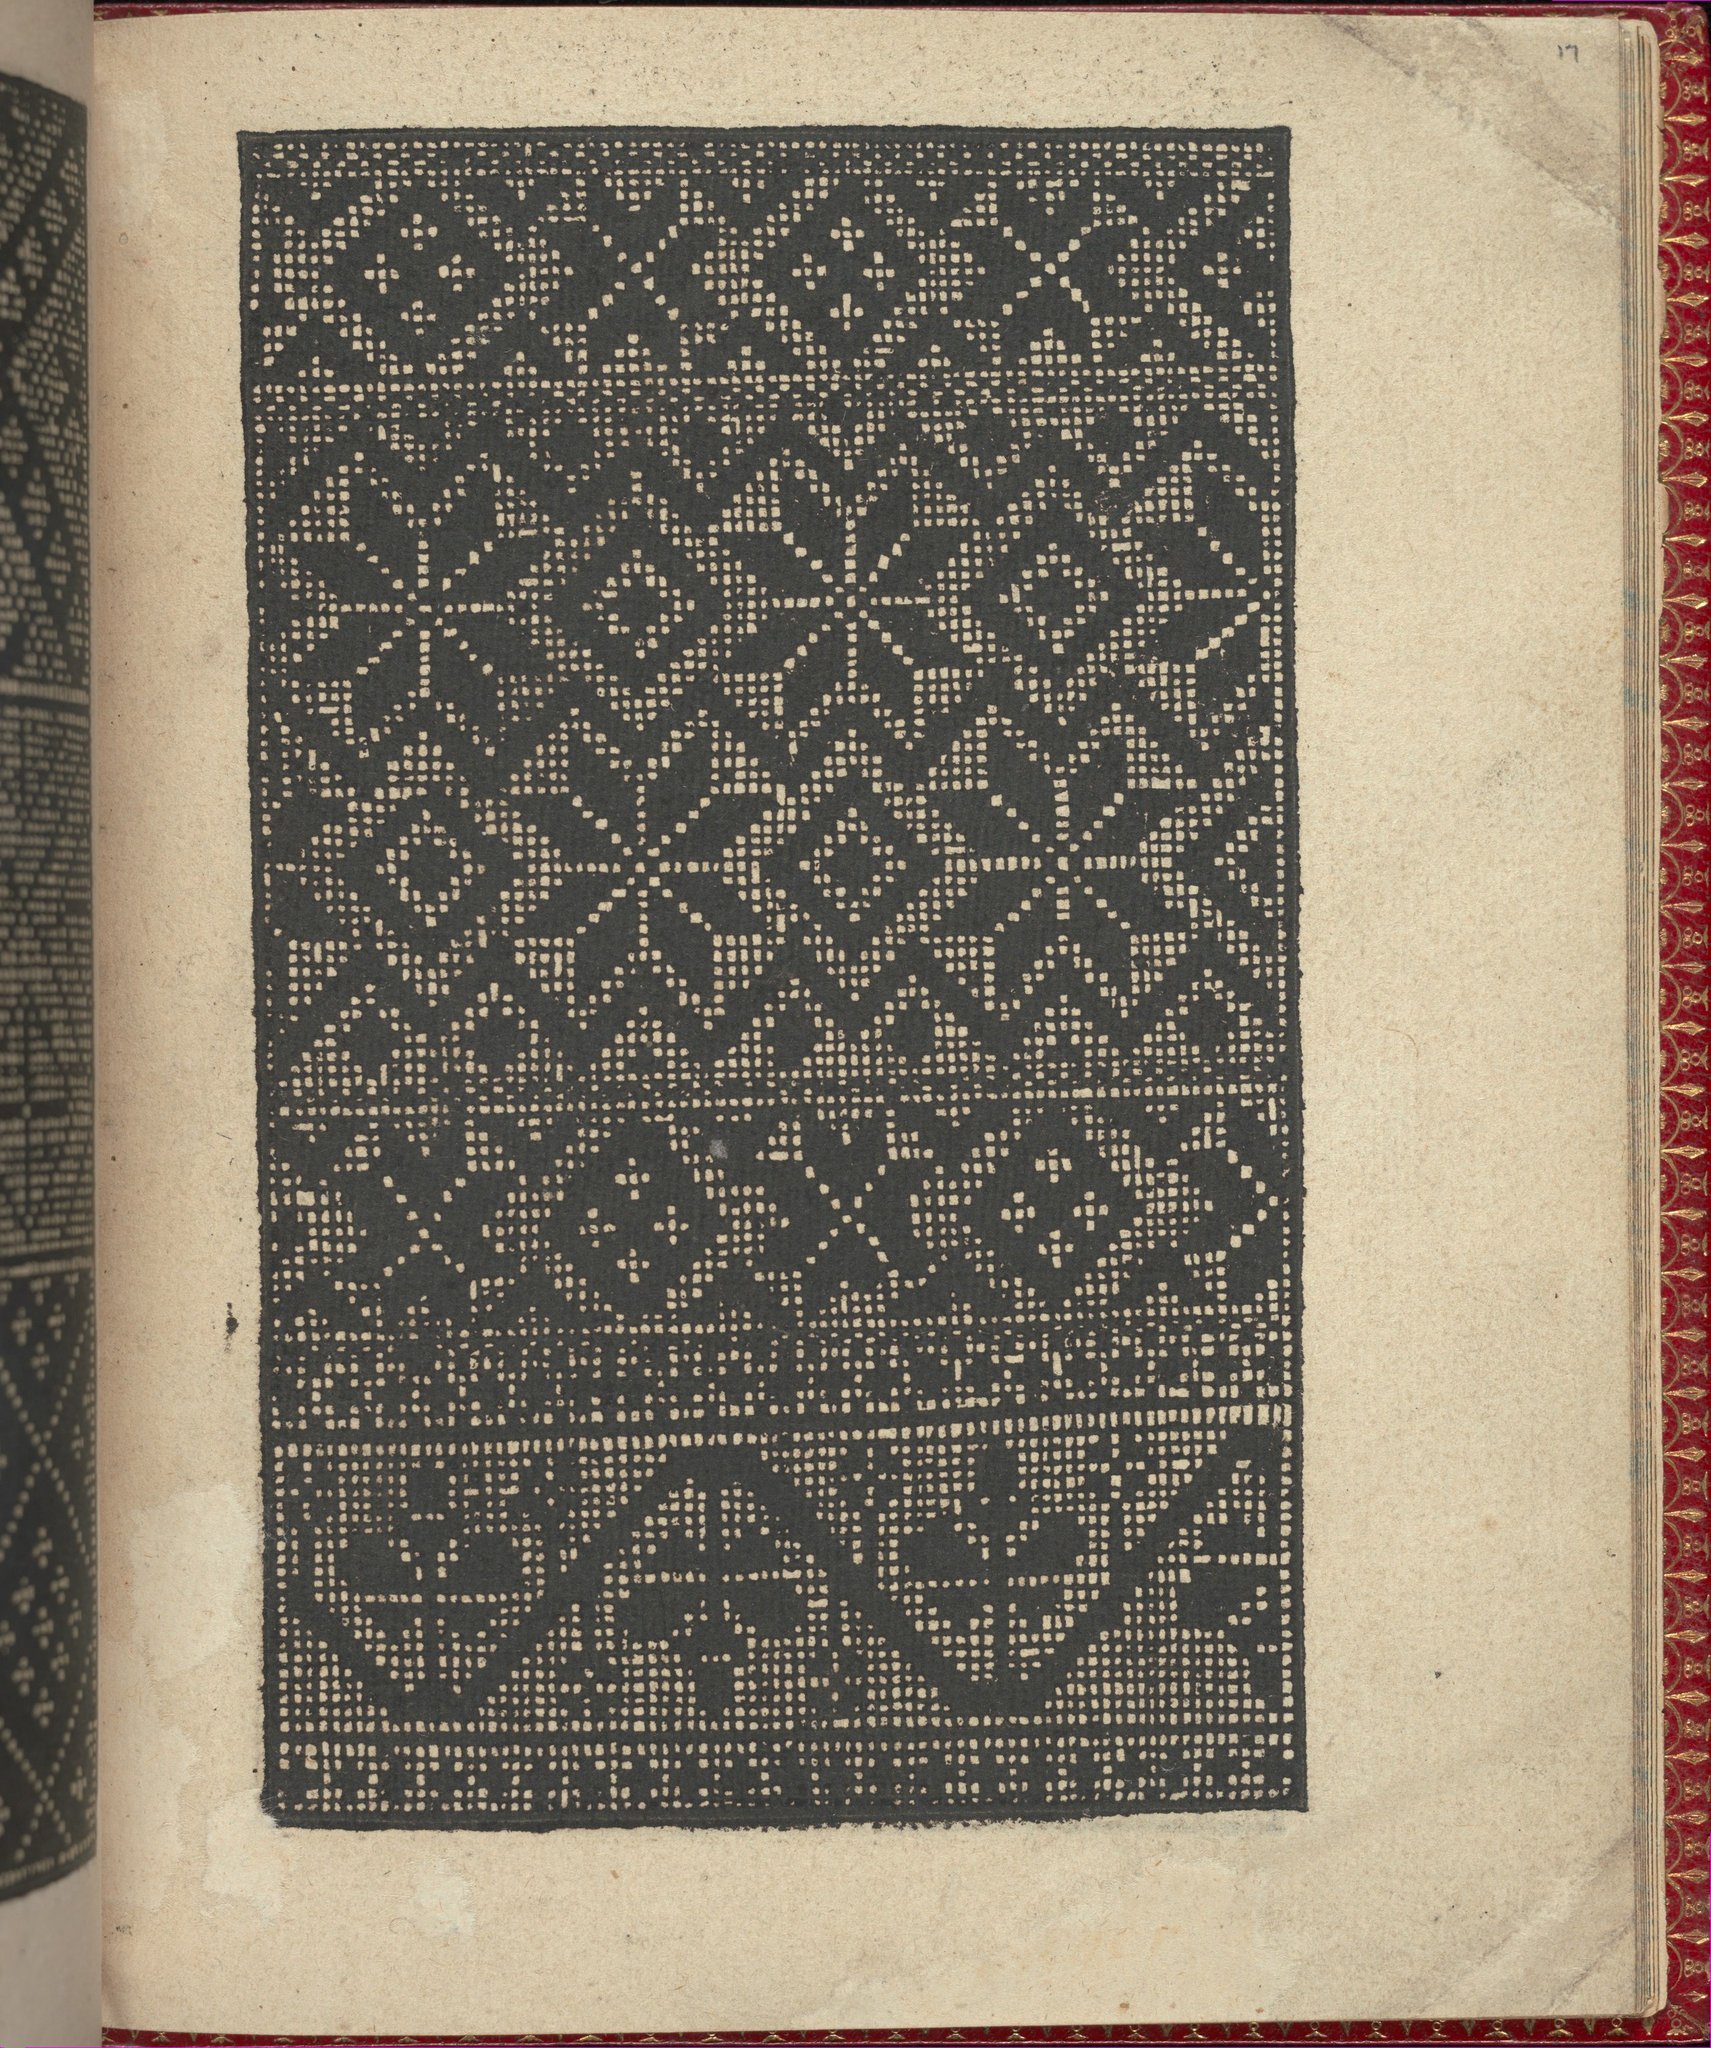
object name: book print ornament architecture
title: Ce est ung tractat de la noble art de leguille ascavoir ouvraiges de spaigne... page 17 (recto)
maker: willem vosterman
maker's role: printer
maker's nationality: netherlandish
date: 1527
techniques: woodcut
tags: ornament